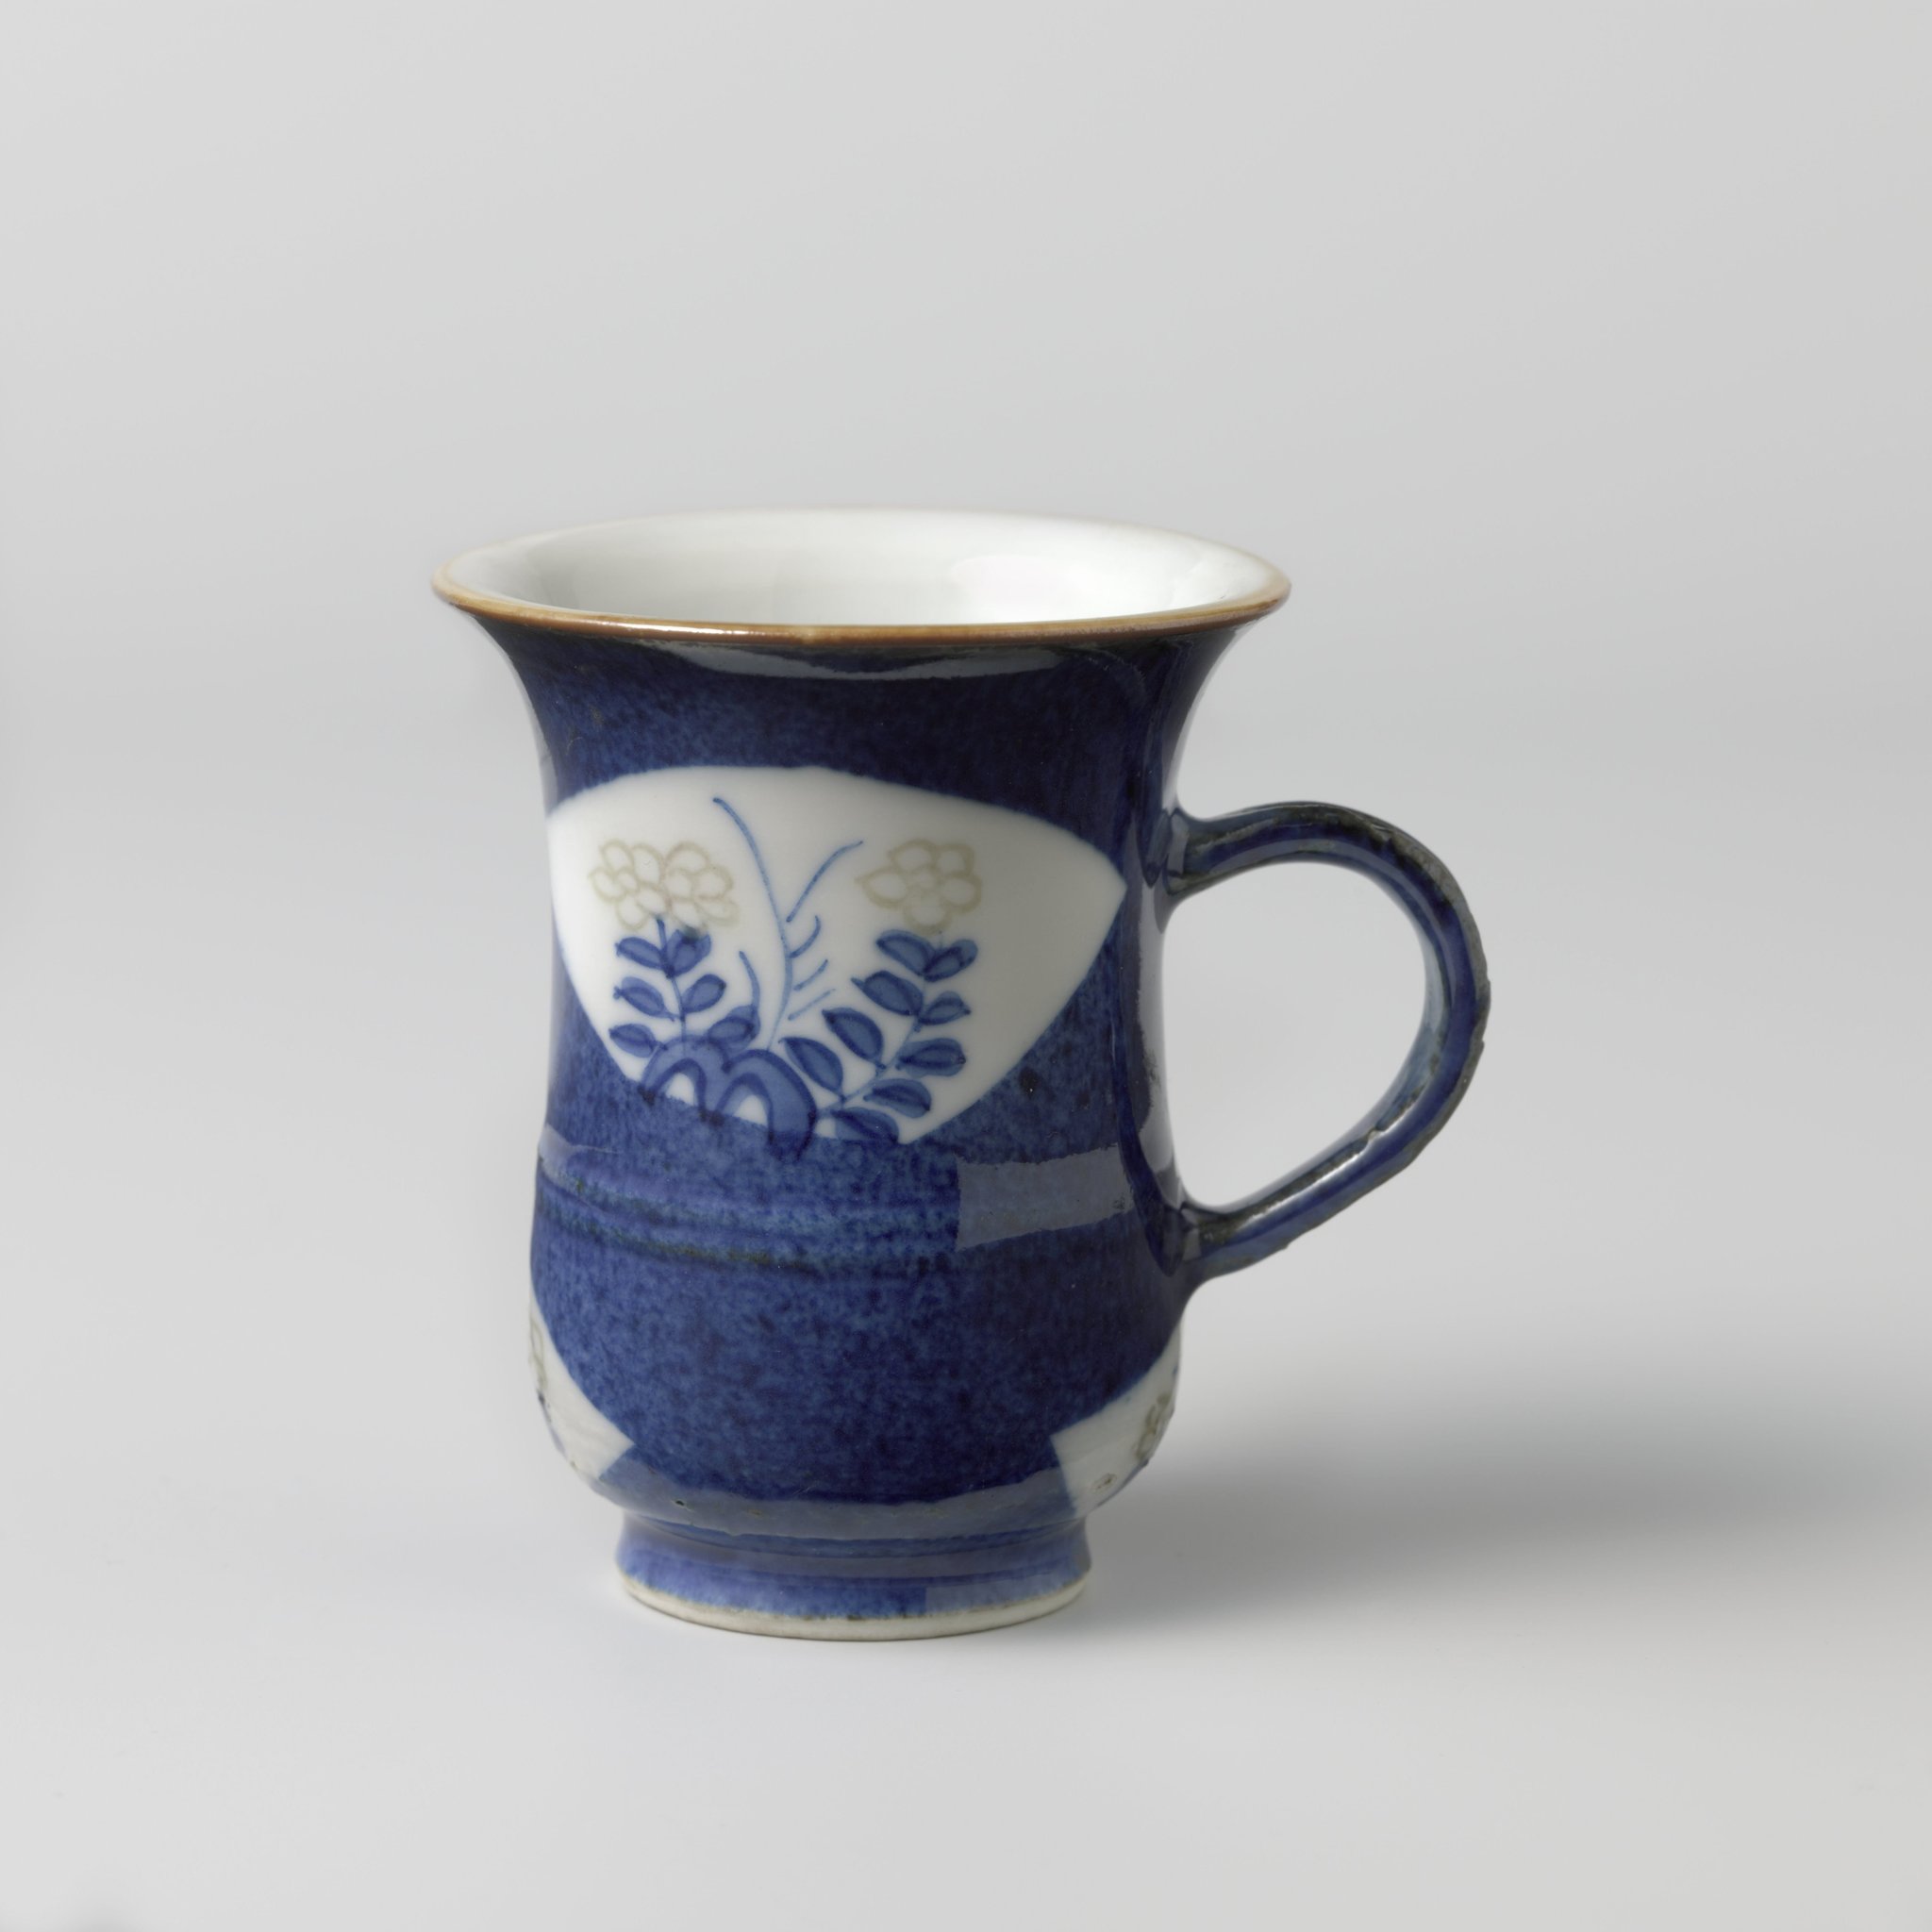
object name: cup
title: Bell-shaped cup with powder blue and fan-shaped panels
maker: Anonymous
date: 1700-1724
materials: cobalt, glaze, paint, porcelain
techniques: firing, turning, vitrification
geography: china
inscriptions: collector's mark: ‘N=732’